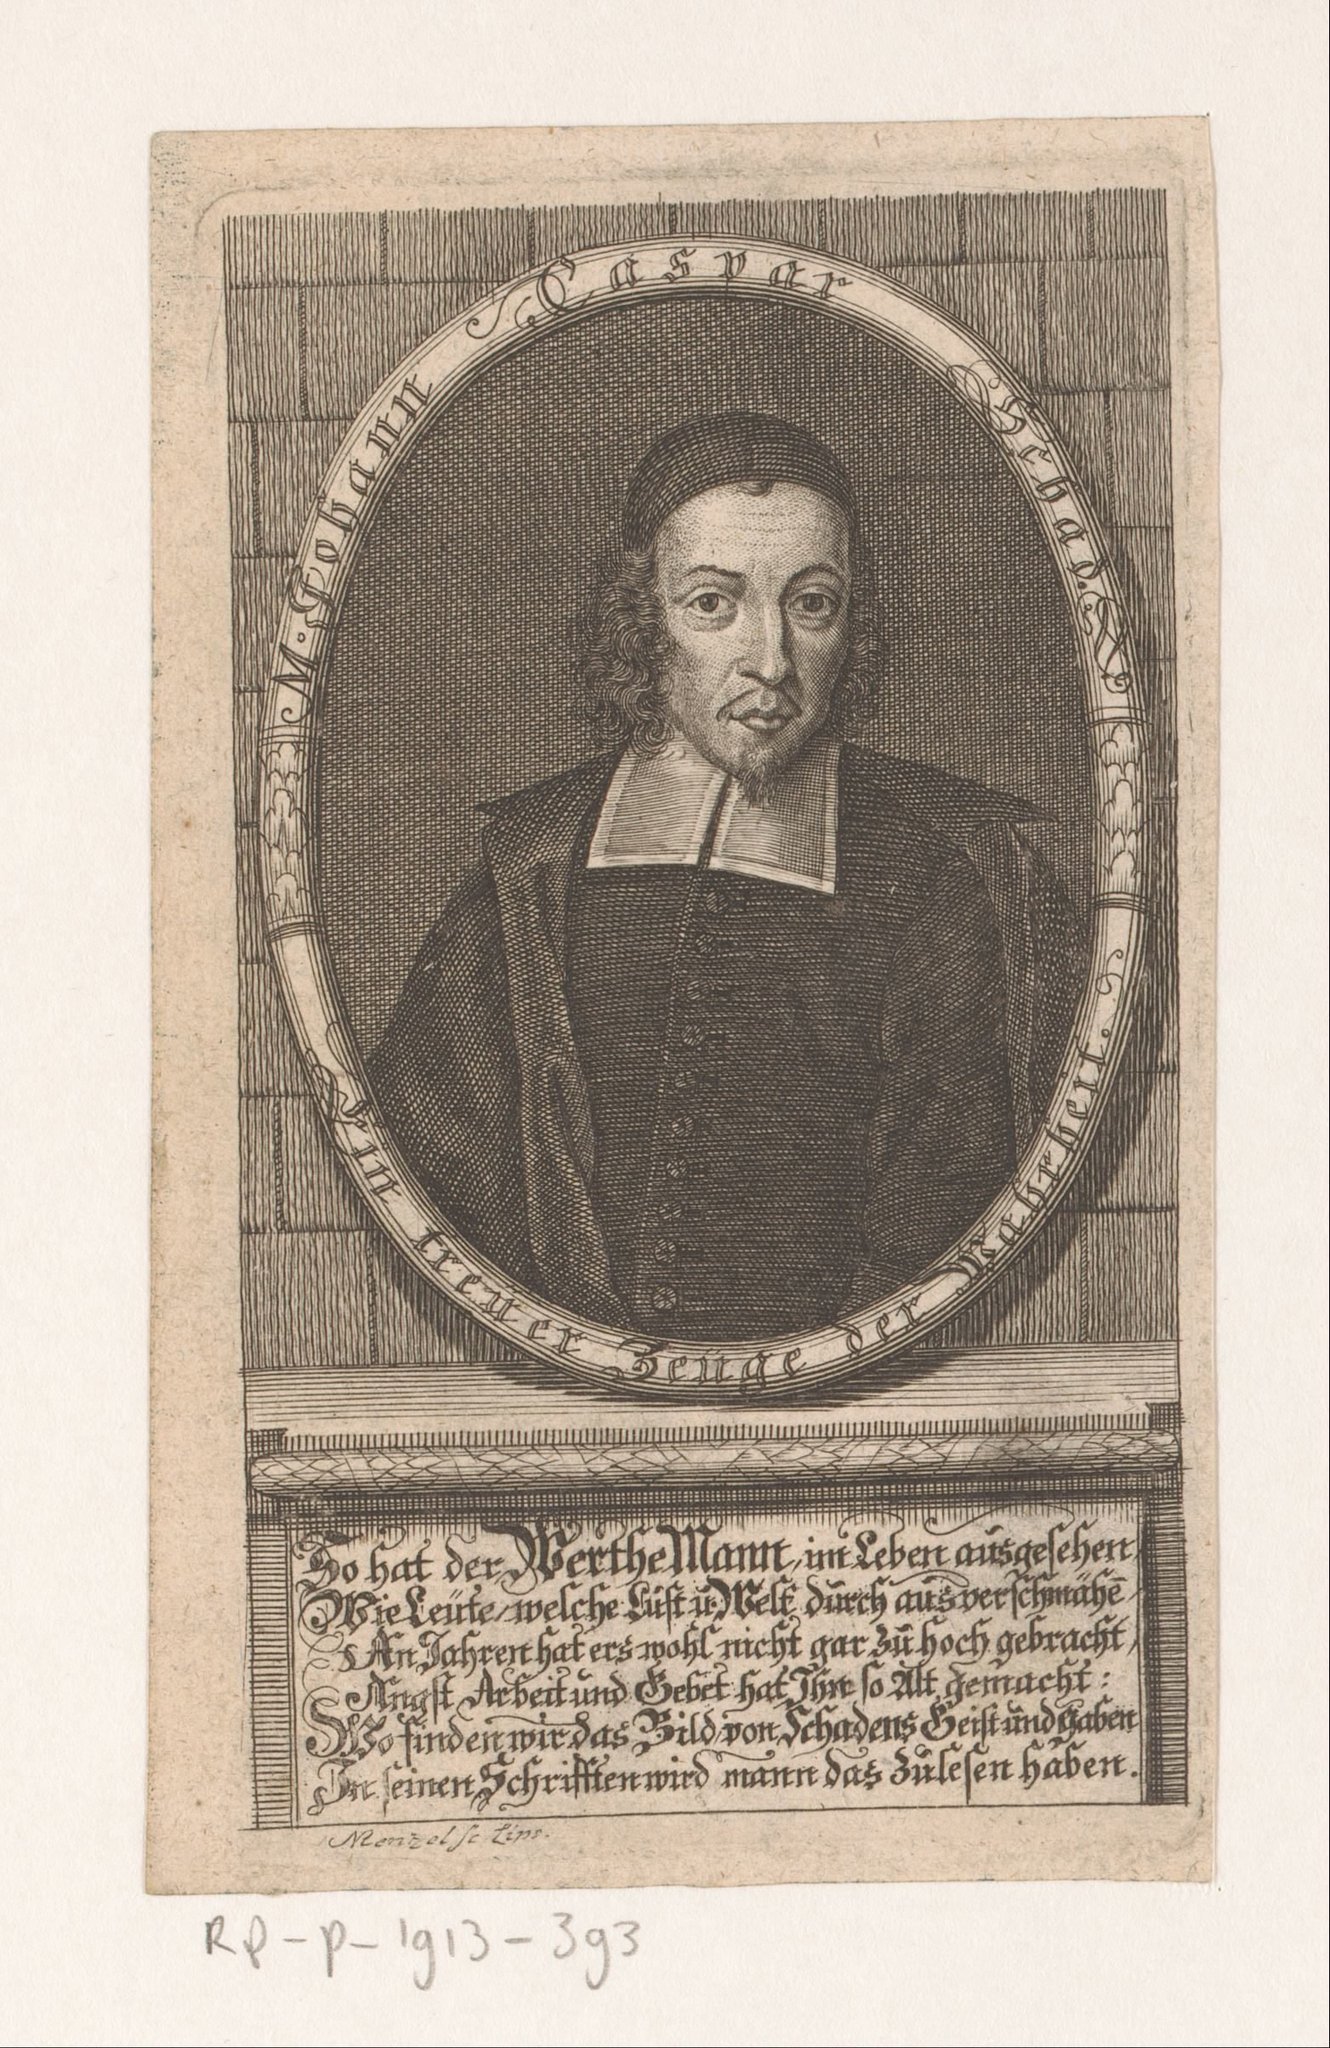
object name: print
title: Portret van Johann Caspar Schade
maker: johann georg mentzel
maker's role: print maker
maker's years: 1677-1743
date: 1687-1743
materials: paper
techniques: engraving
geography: leipzig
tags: berlin, theologian, historical persons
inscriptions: collector's mark: Lugt 2228